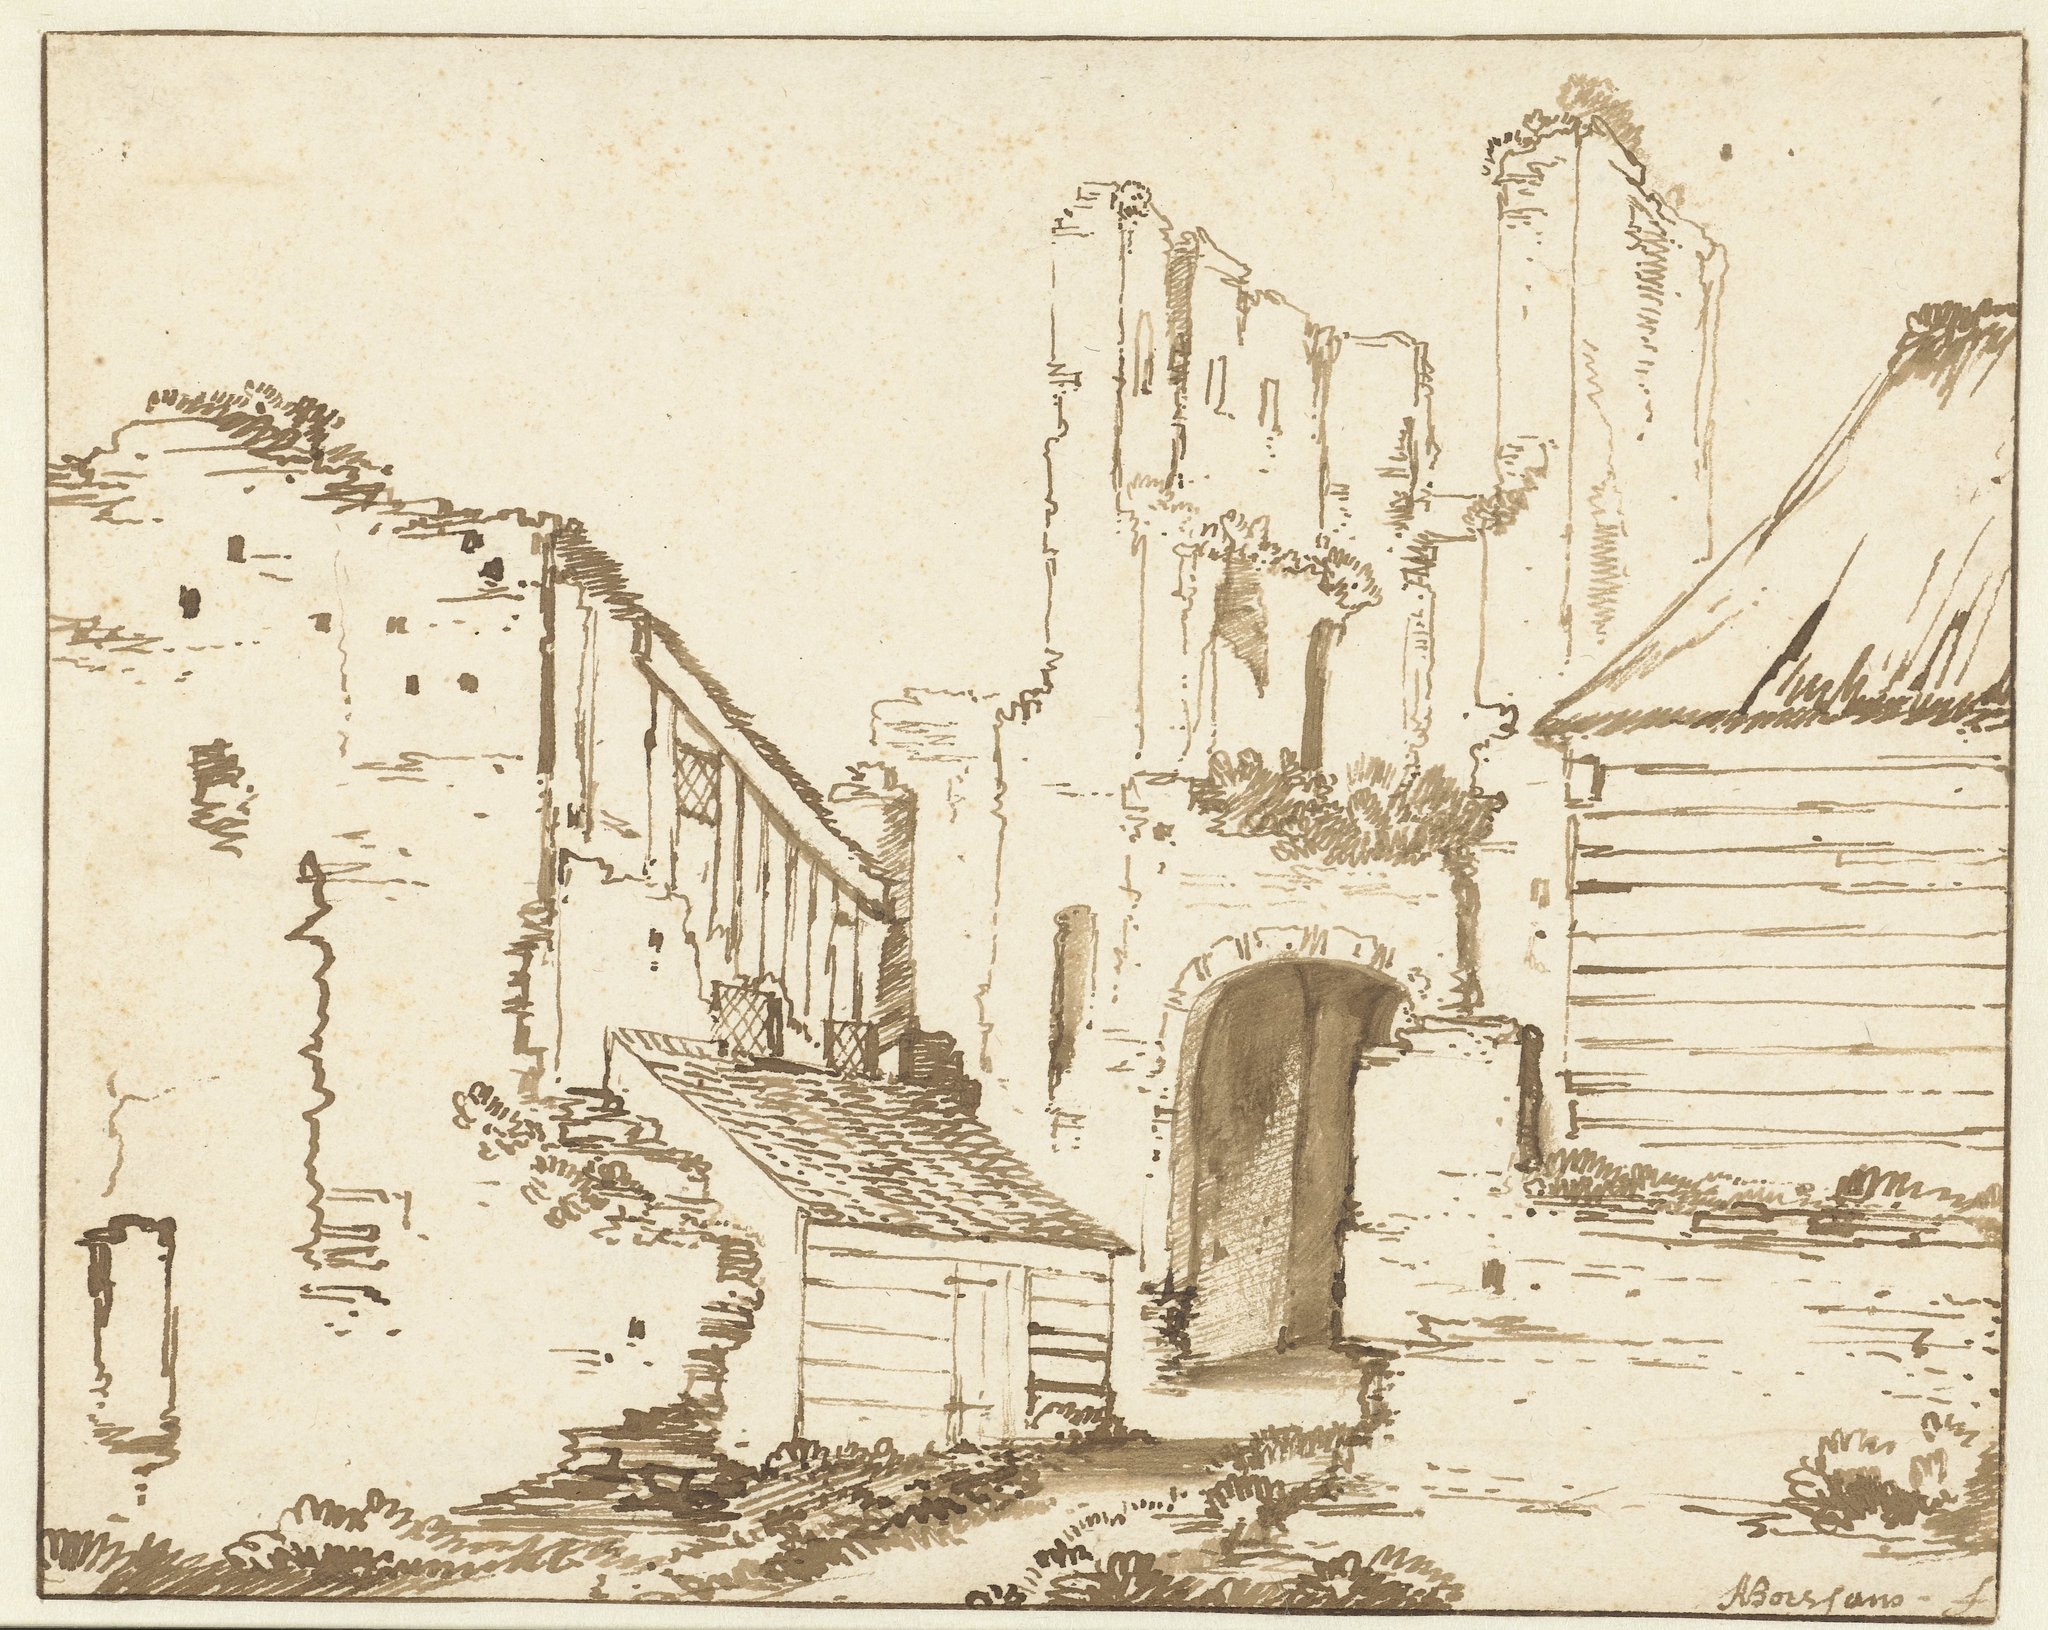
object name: drawing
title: Voorpoort van de Ruïne van Brederode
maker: anthonie van borssom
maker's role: draughtsman, print maker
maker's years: 1629-1677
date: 1640-1677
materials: ink, paper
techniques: brush, pen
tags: landscape with ruins, ruin of a dwelling, house, castle, etc.